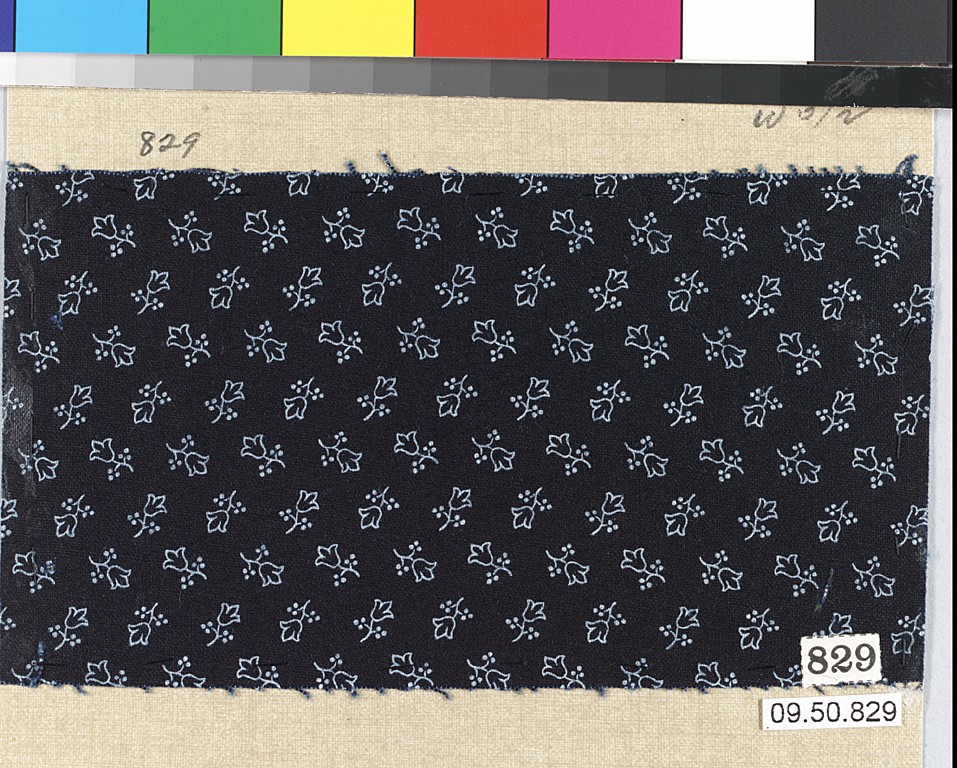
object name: piece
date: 1801-1900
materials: cotton